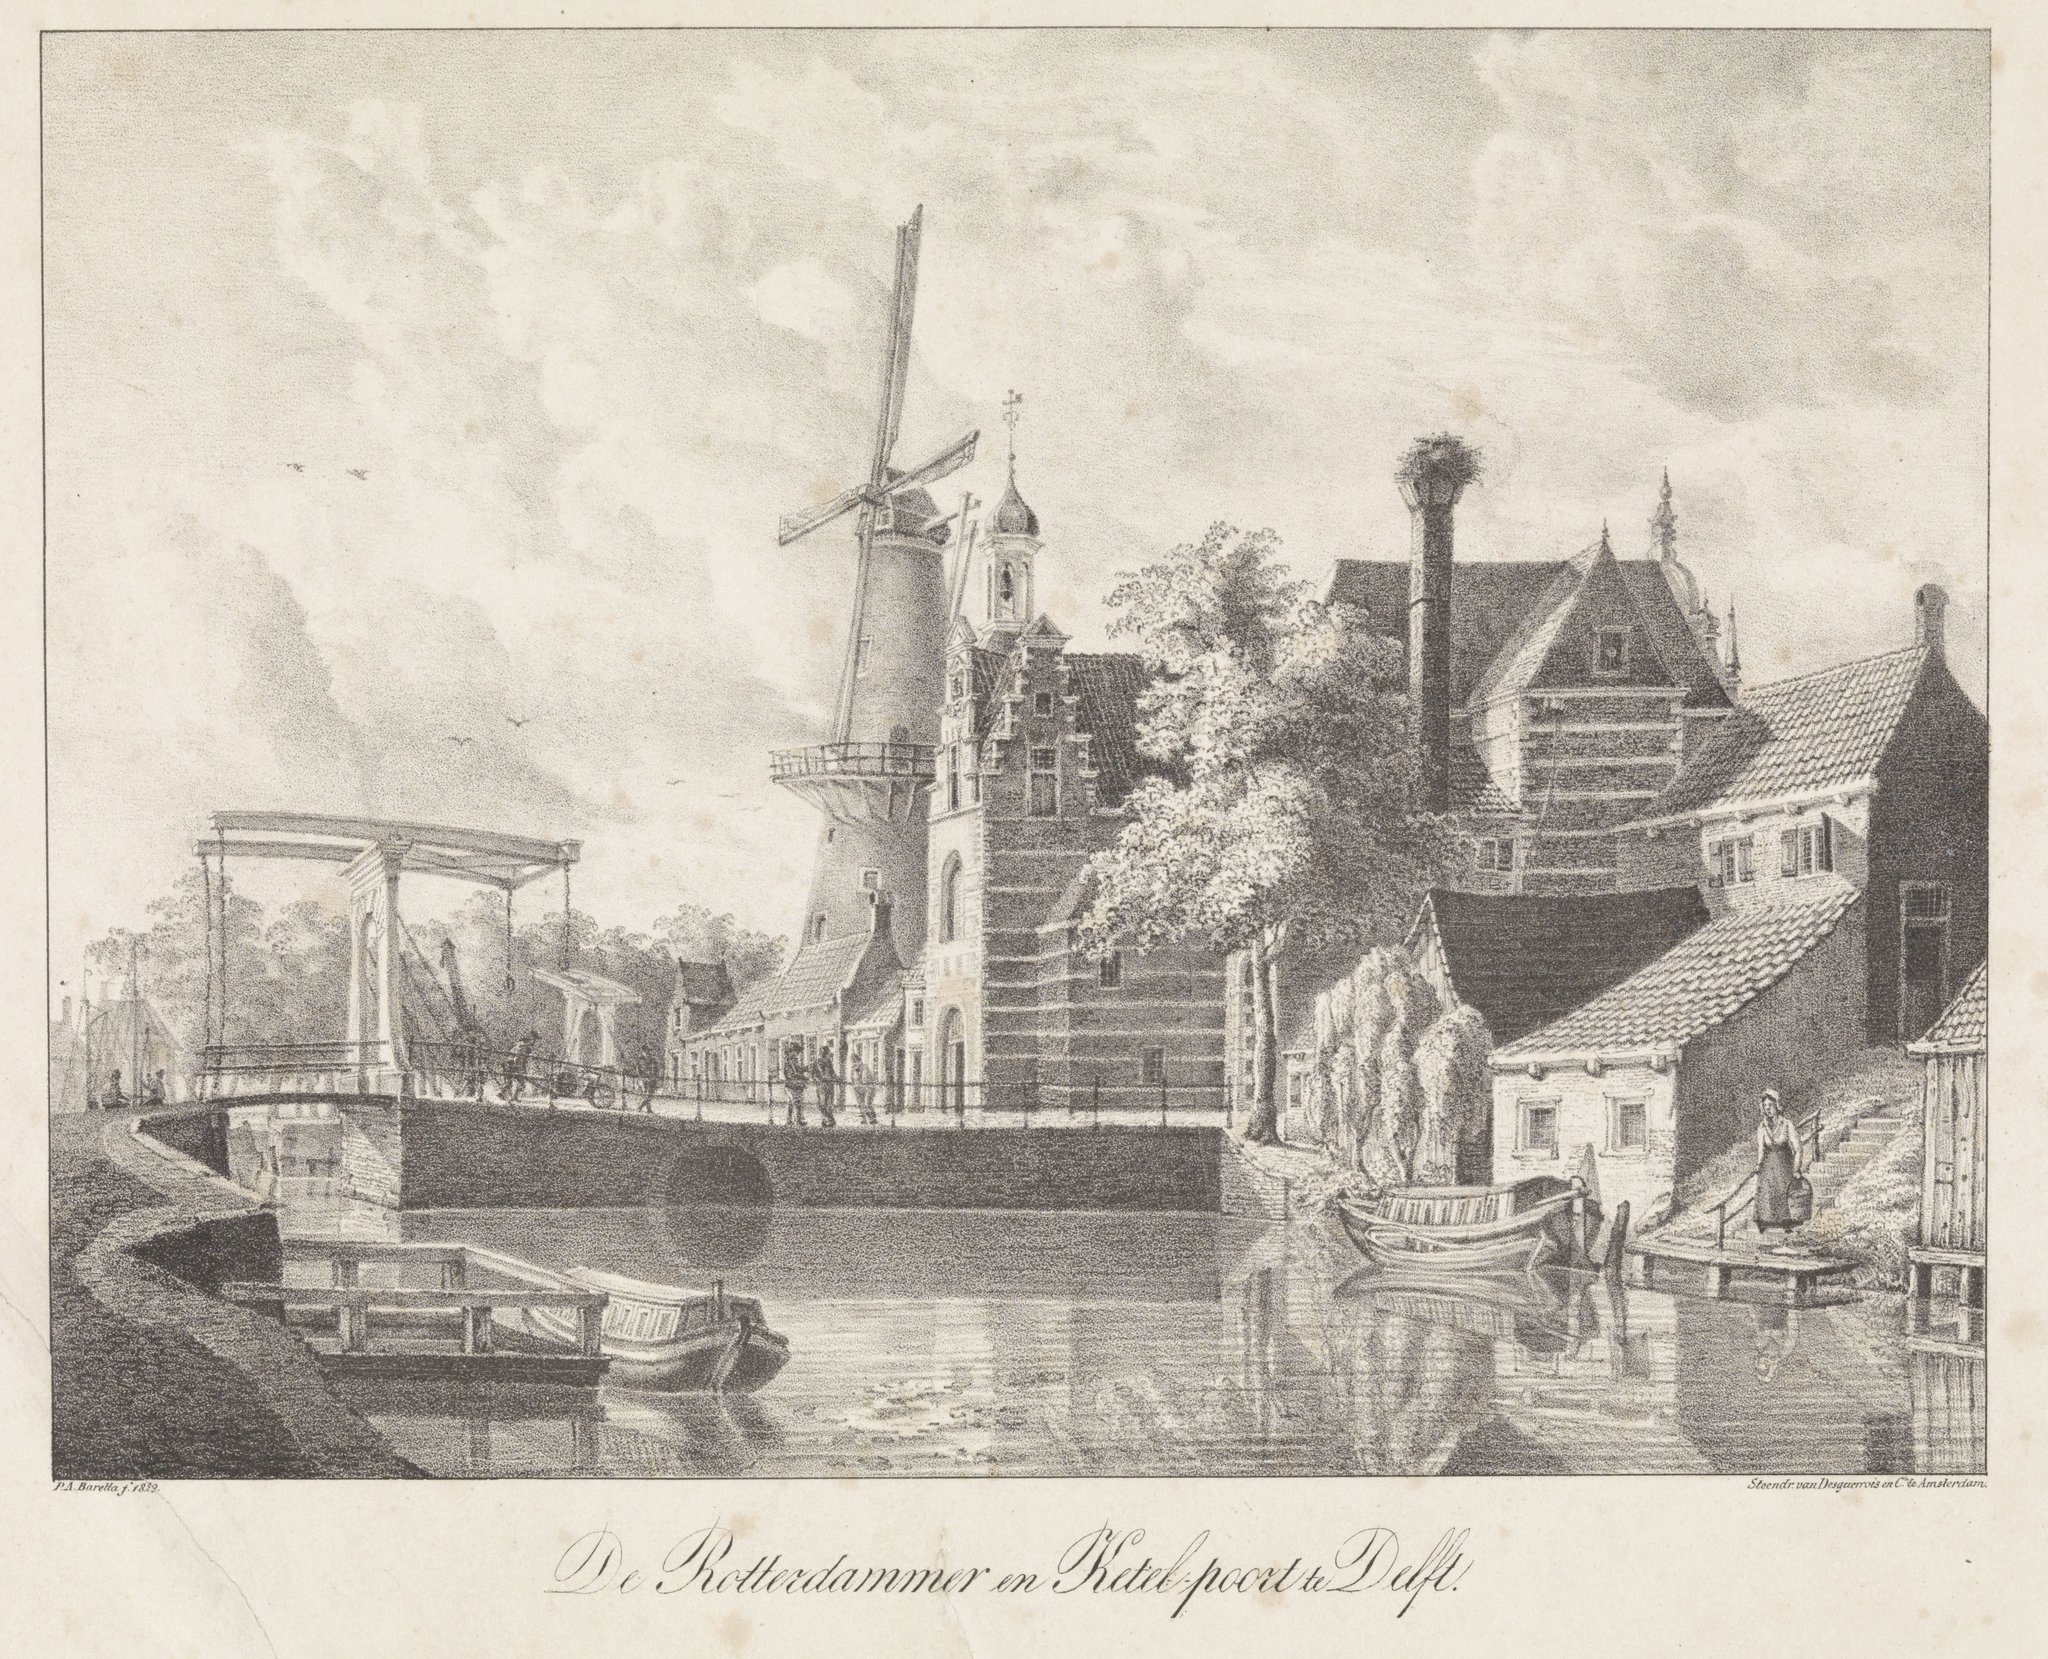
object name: print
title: Rotterdamse Poort en Ketelpoort te Delft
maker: petrus augustus beretta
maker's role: draughtsman, print maker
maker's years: 1805-1866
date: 1829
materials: paper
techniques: lithograph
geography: amsterdam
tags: drawbridge ~ fortified city, rowing-boat, canoe, etc., windmill in landscape (+ city(-scape) with figures, staffage), delft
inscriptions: collector's mark: Lugt 2233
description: Deze prent maakte deel uit van de uitgave: Une promenade dans la Haye et ses environs : vues dessinées d'après nature par C.C.A. Last et J.C. van Pappelendam, uitgegeven in 1833.